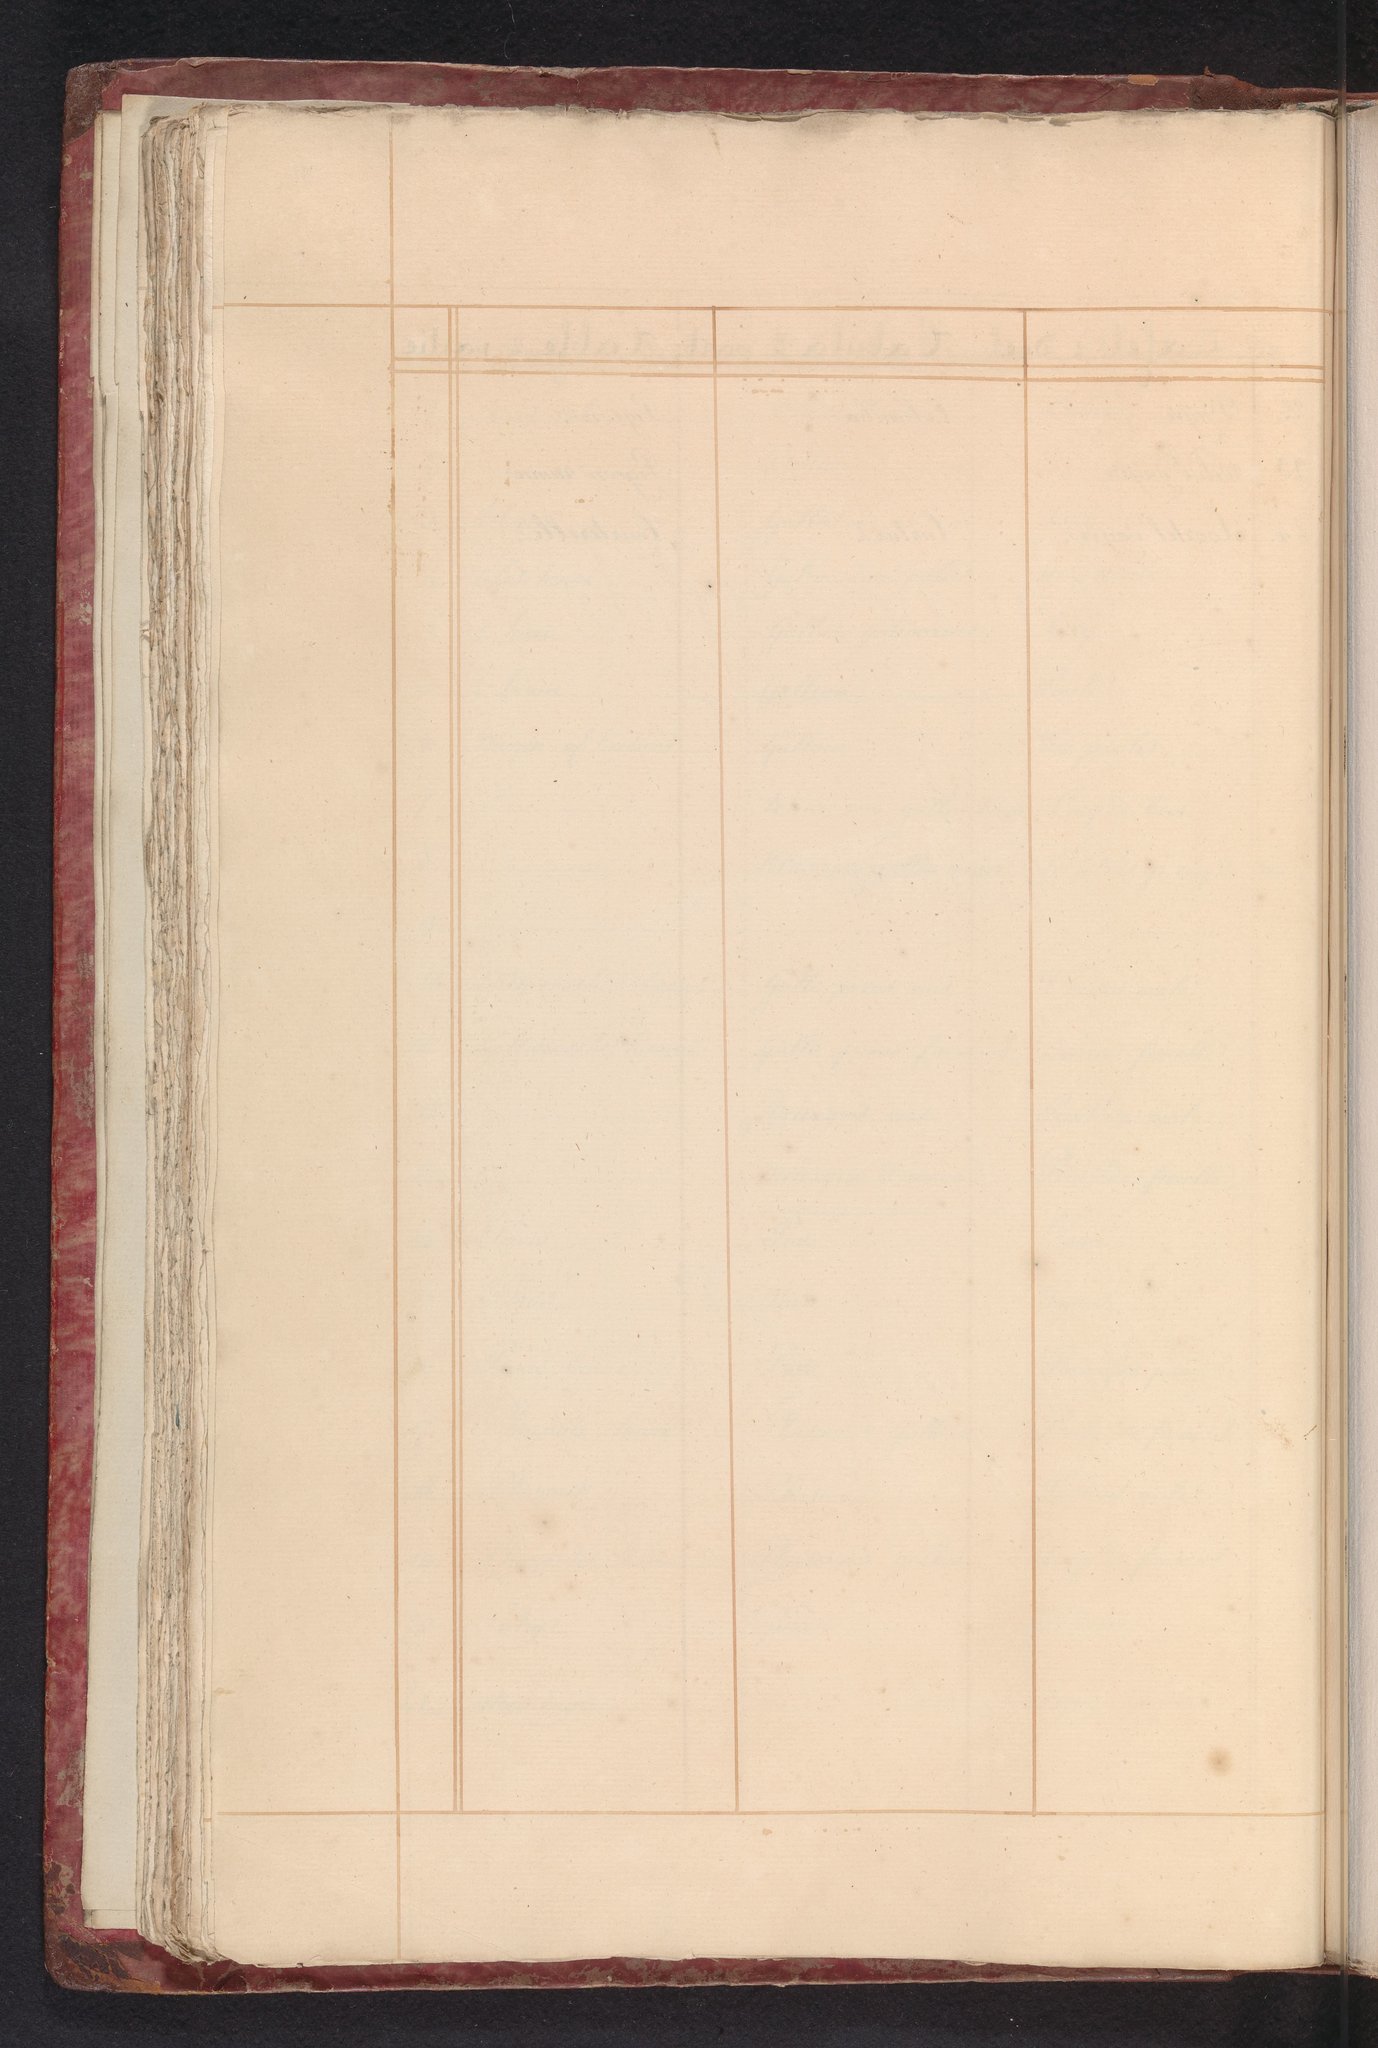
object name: manuscript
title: Oningevuld schema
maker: joseph van huerne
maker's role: kunstliefhebber, mecenas, verzamelaar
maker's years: 1752-1844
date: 1809-1814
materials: ink, paper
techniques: handwriting, pen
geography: bruges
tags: handwriting, written text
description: Oningevuld schema met drie kolommen. Onderdeel van het eerste album met tekeningen van vogels. Derde van twaalf albums met tekeningen van dieren, vogels en planten bekend rond 1600, gemaakt in opdracht van keizer Rudolf II. Met toelichting in Nederlands, Latijn en Frans.